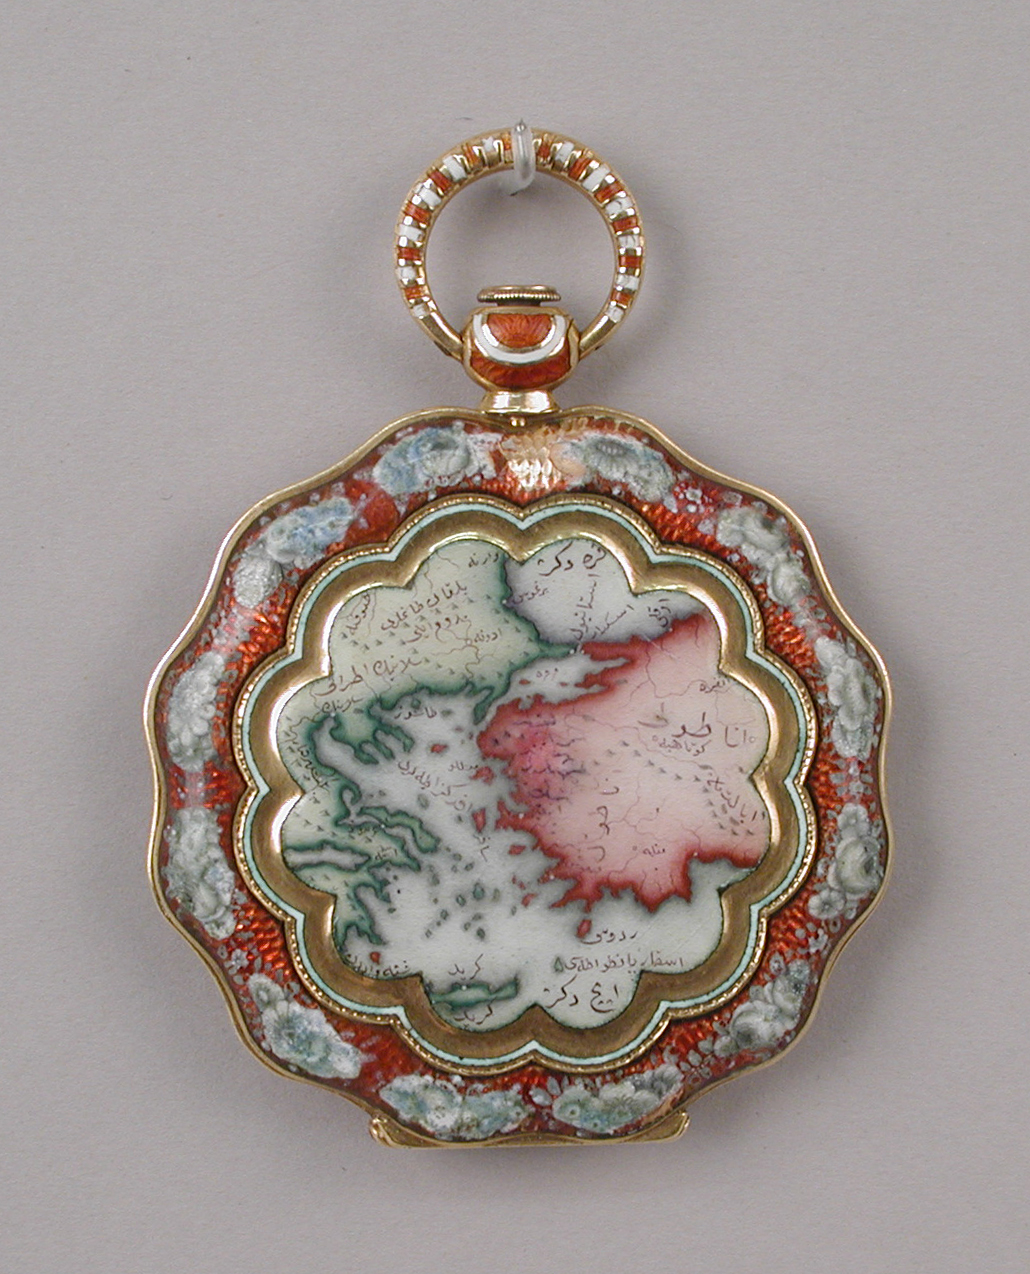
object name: watch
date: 1801-1900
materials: enamel, metal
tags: maps